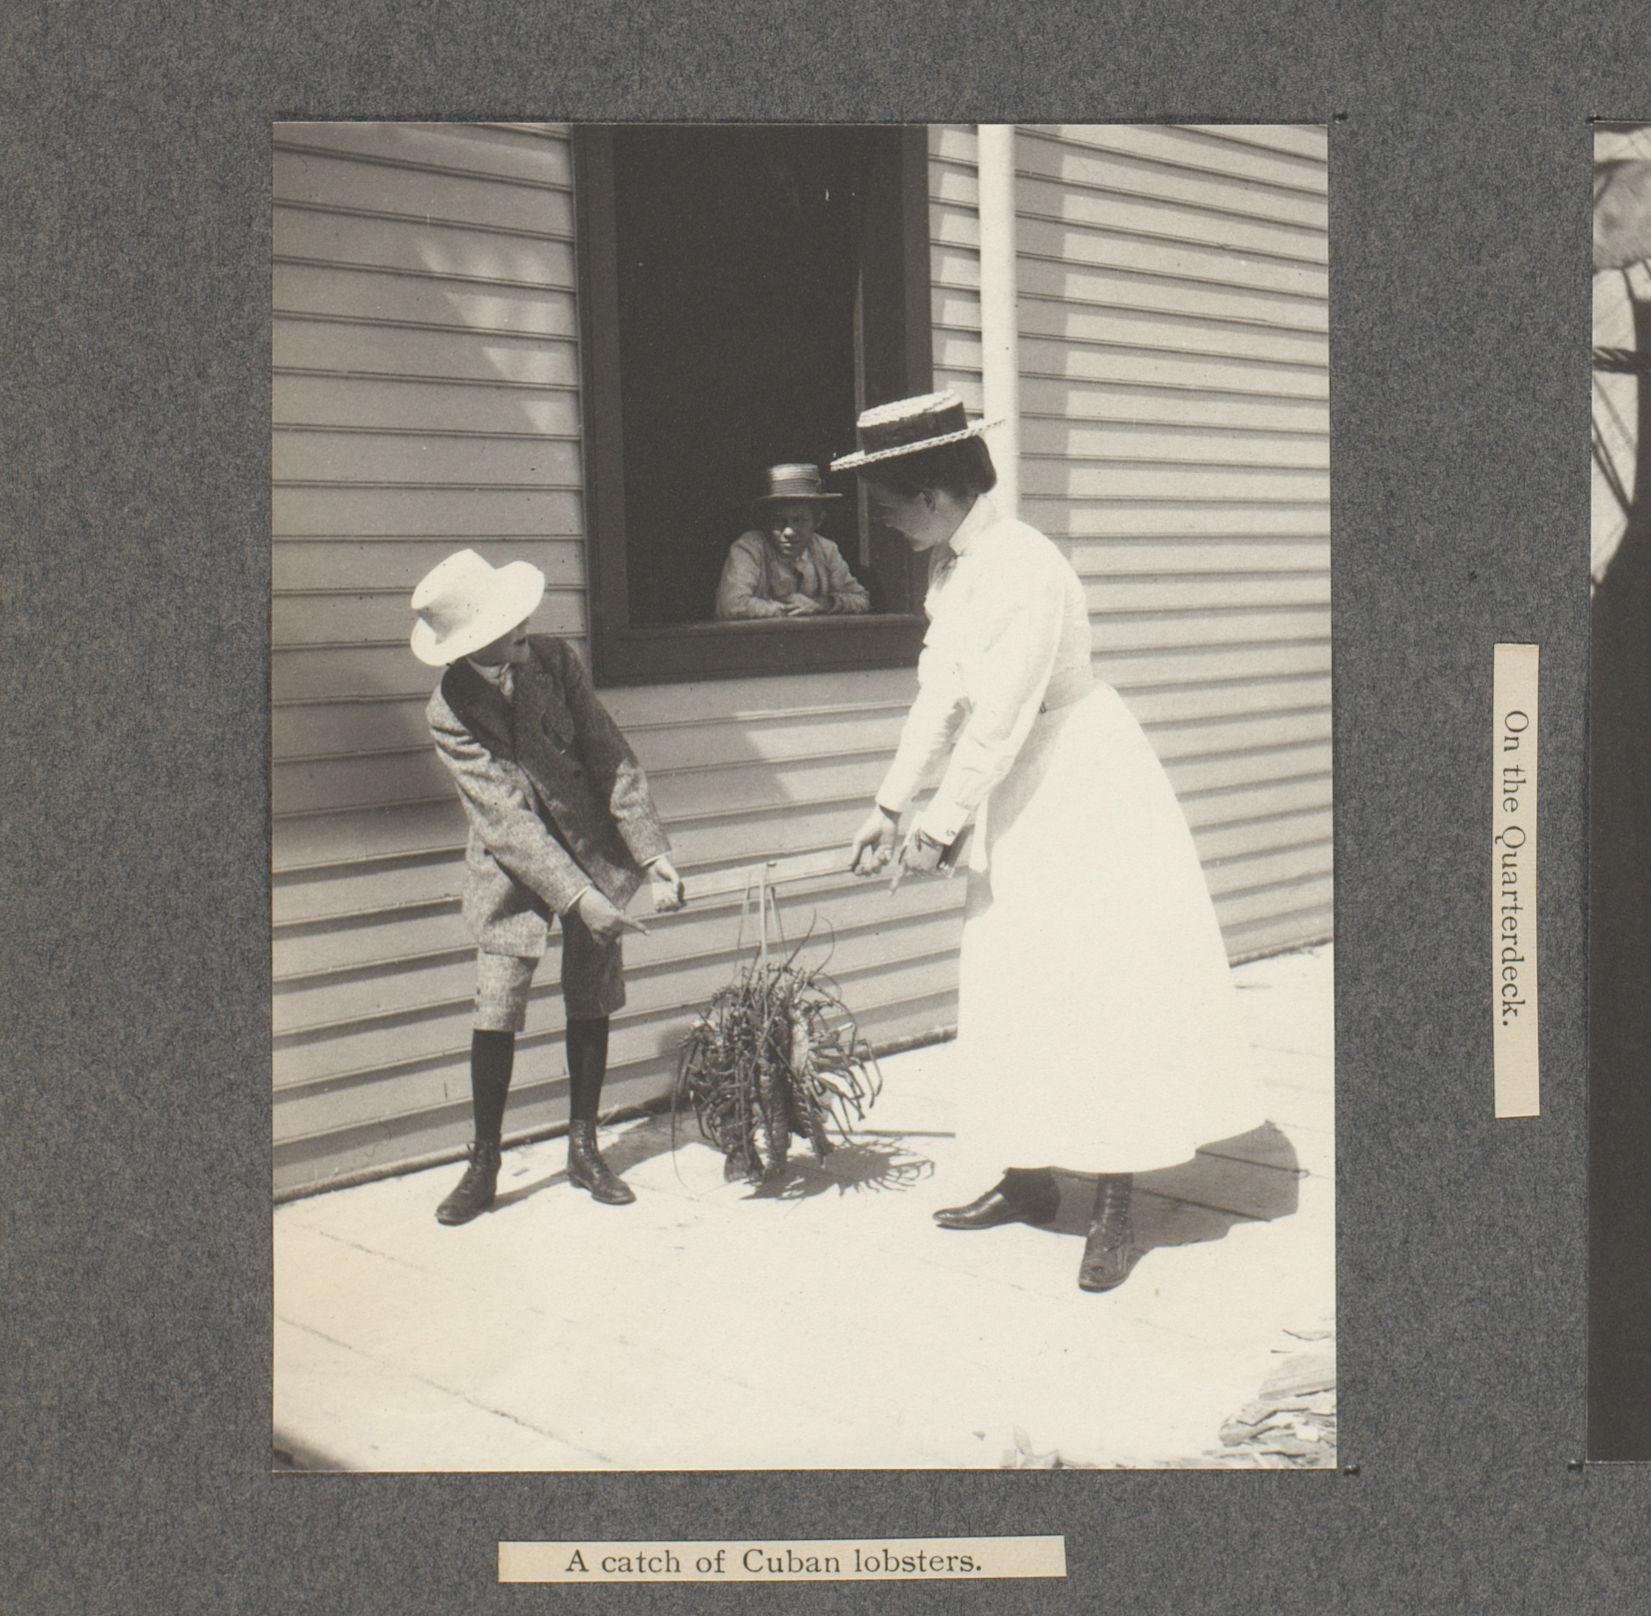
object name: album leaf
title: A catch of Cuban lobsters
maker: Anonymous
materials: paper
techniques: platinum process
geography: matanzas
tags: adult woman, boy (child between toddler and youth), historical persons, fisherman showing catch